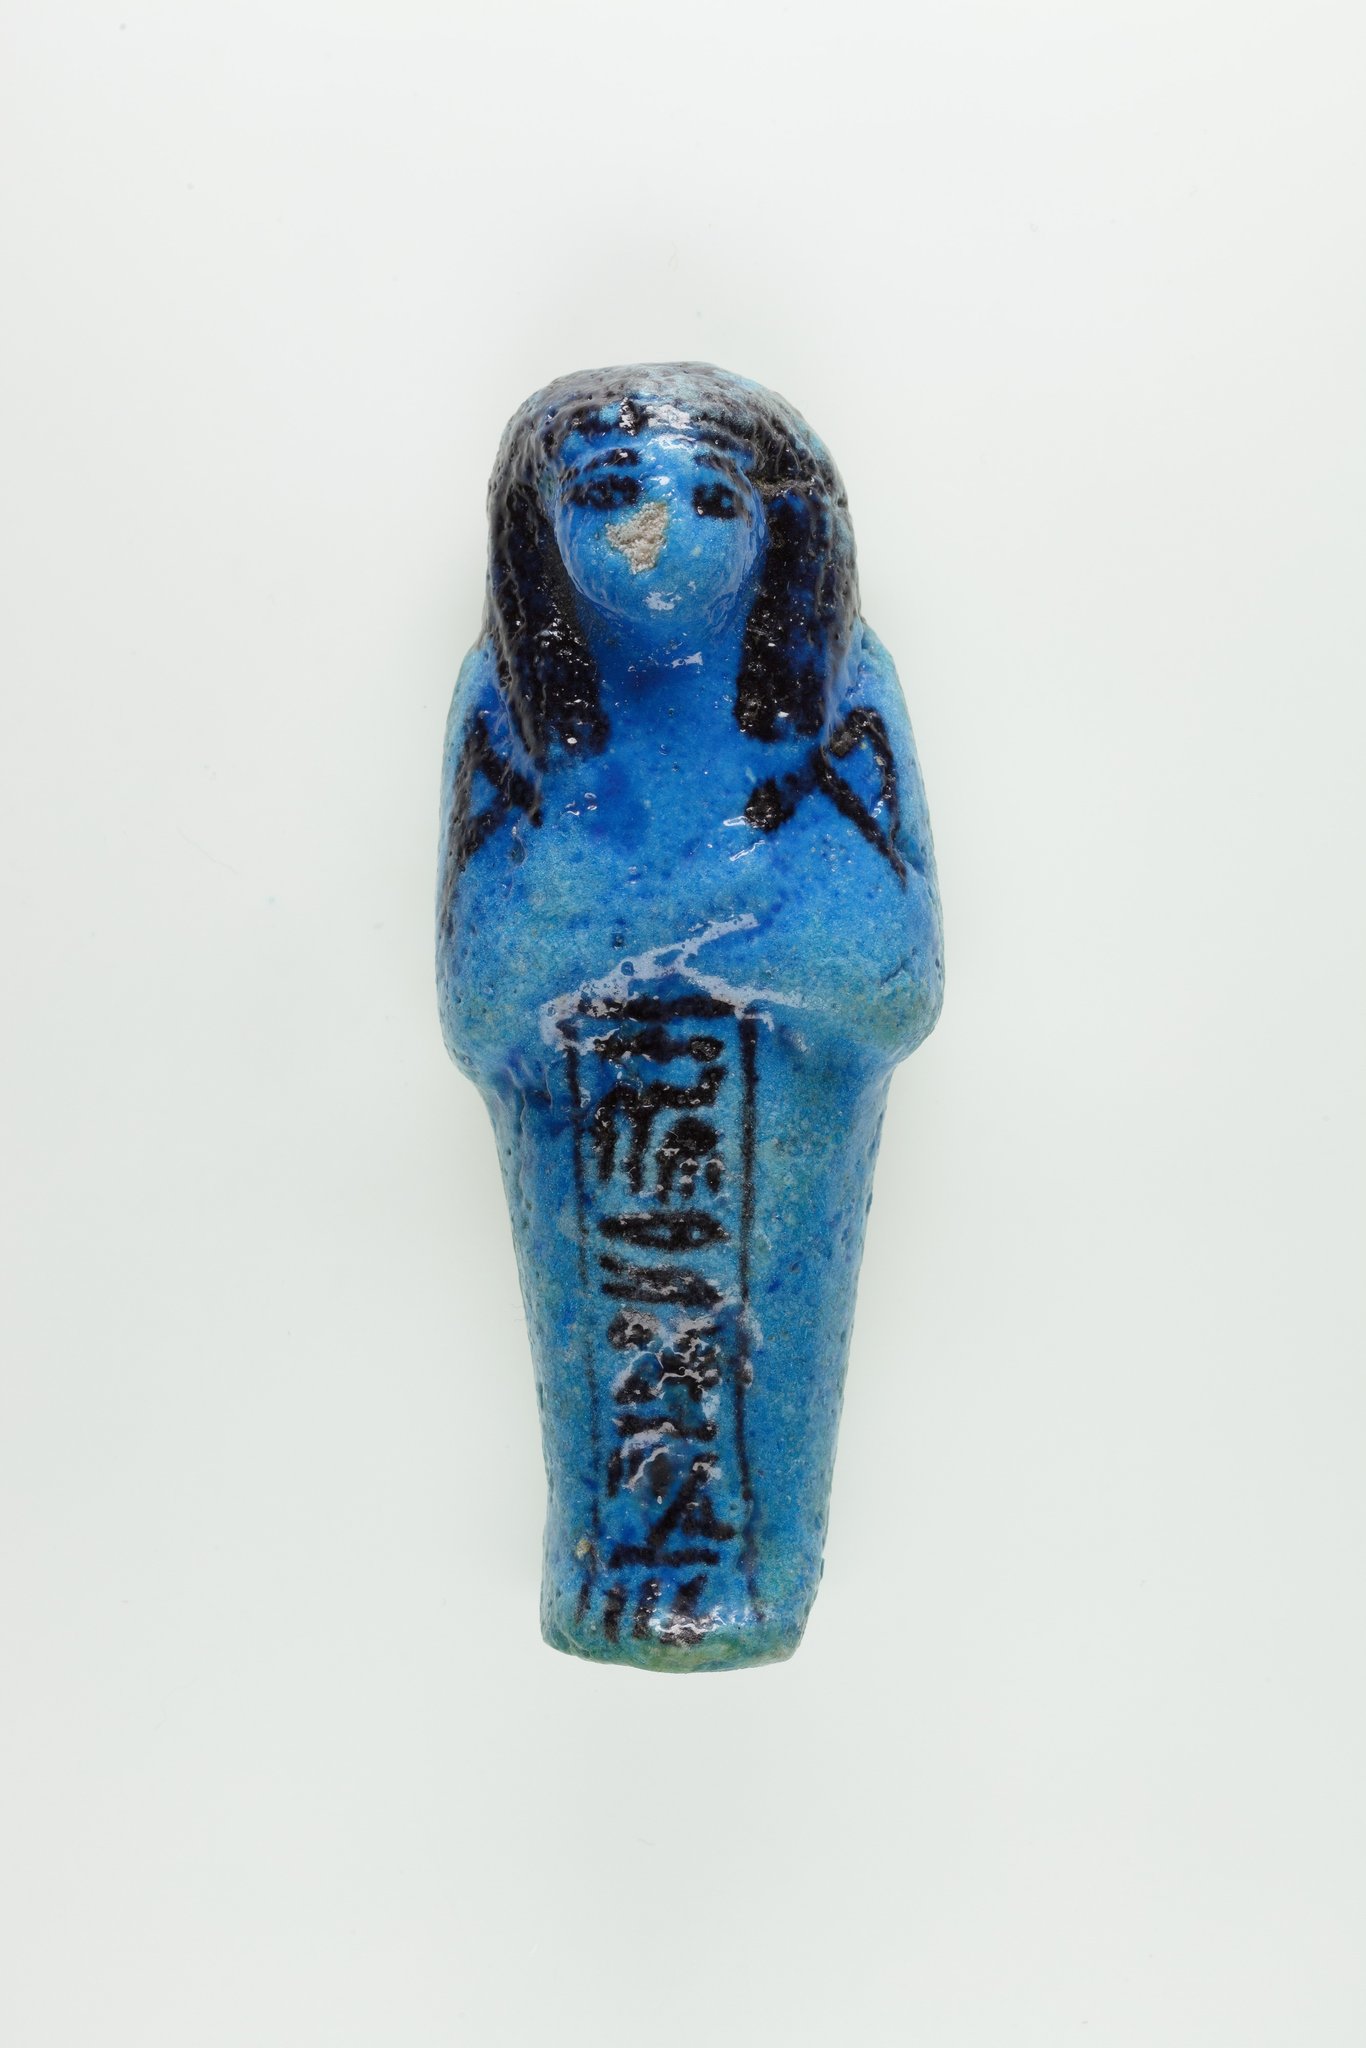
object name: shabti, worker, nauny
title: Worker Shabti of Nauny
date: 1050 BCE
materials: faience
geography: egypt